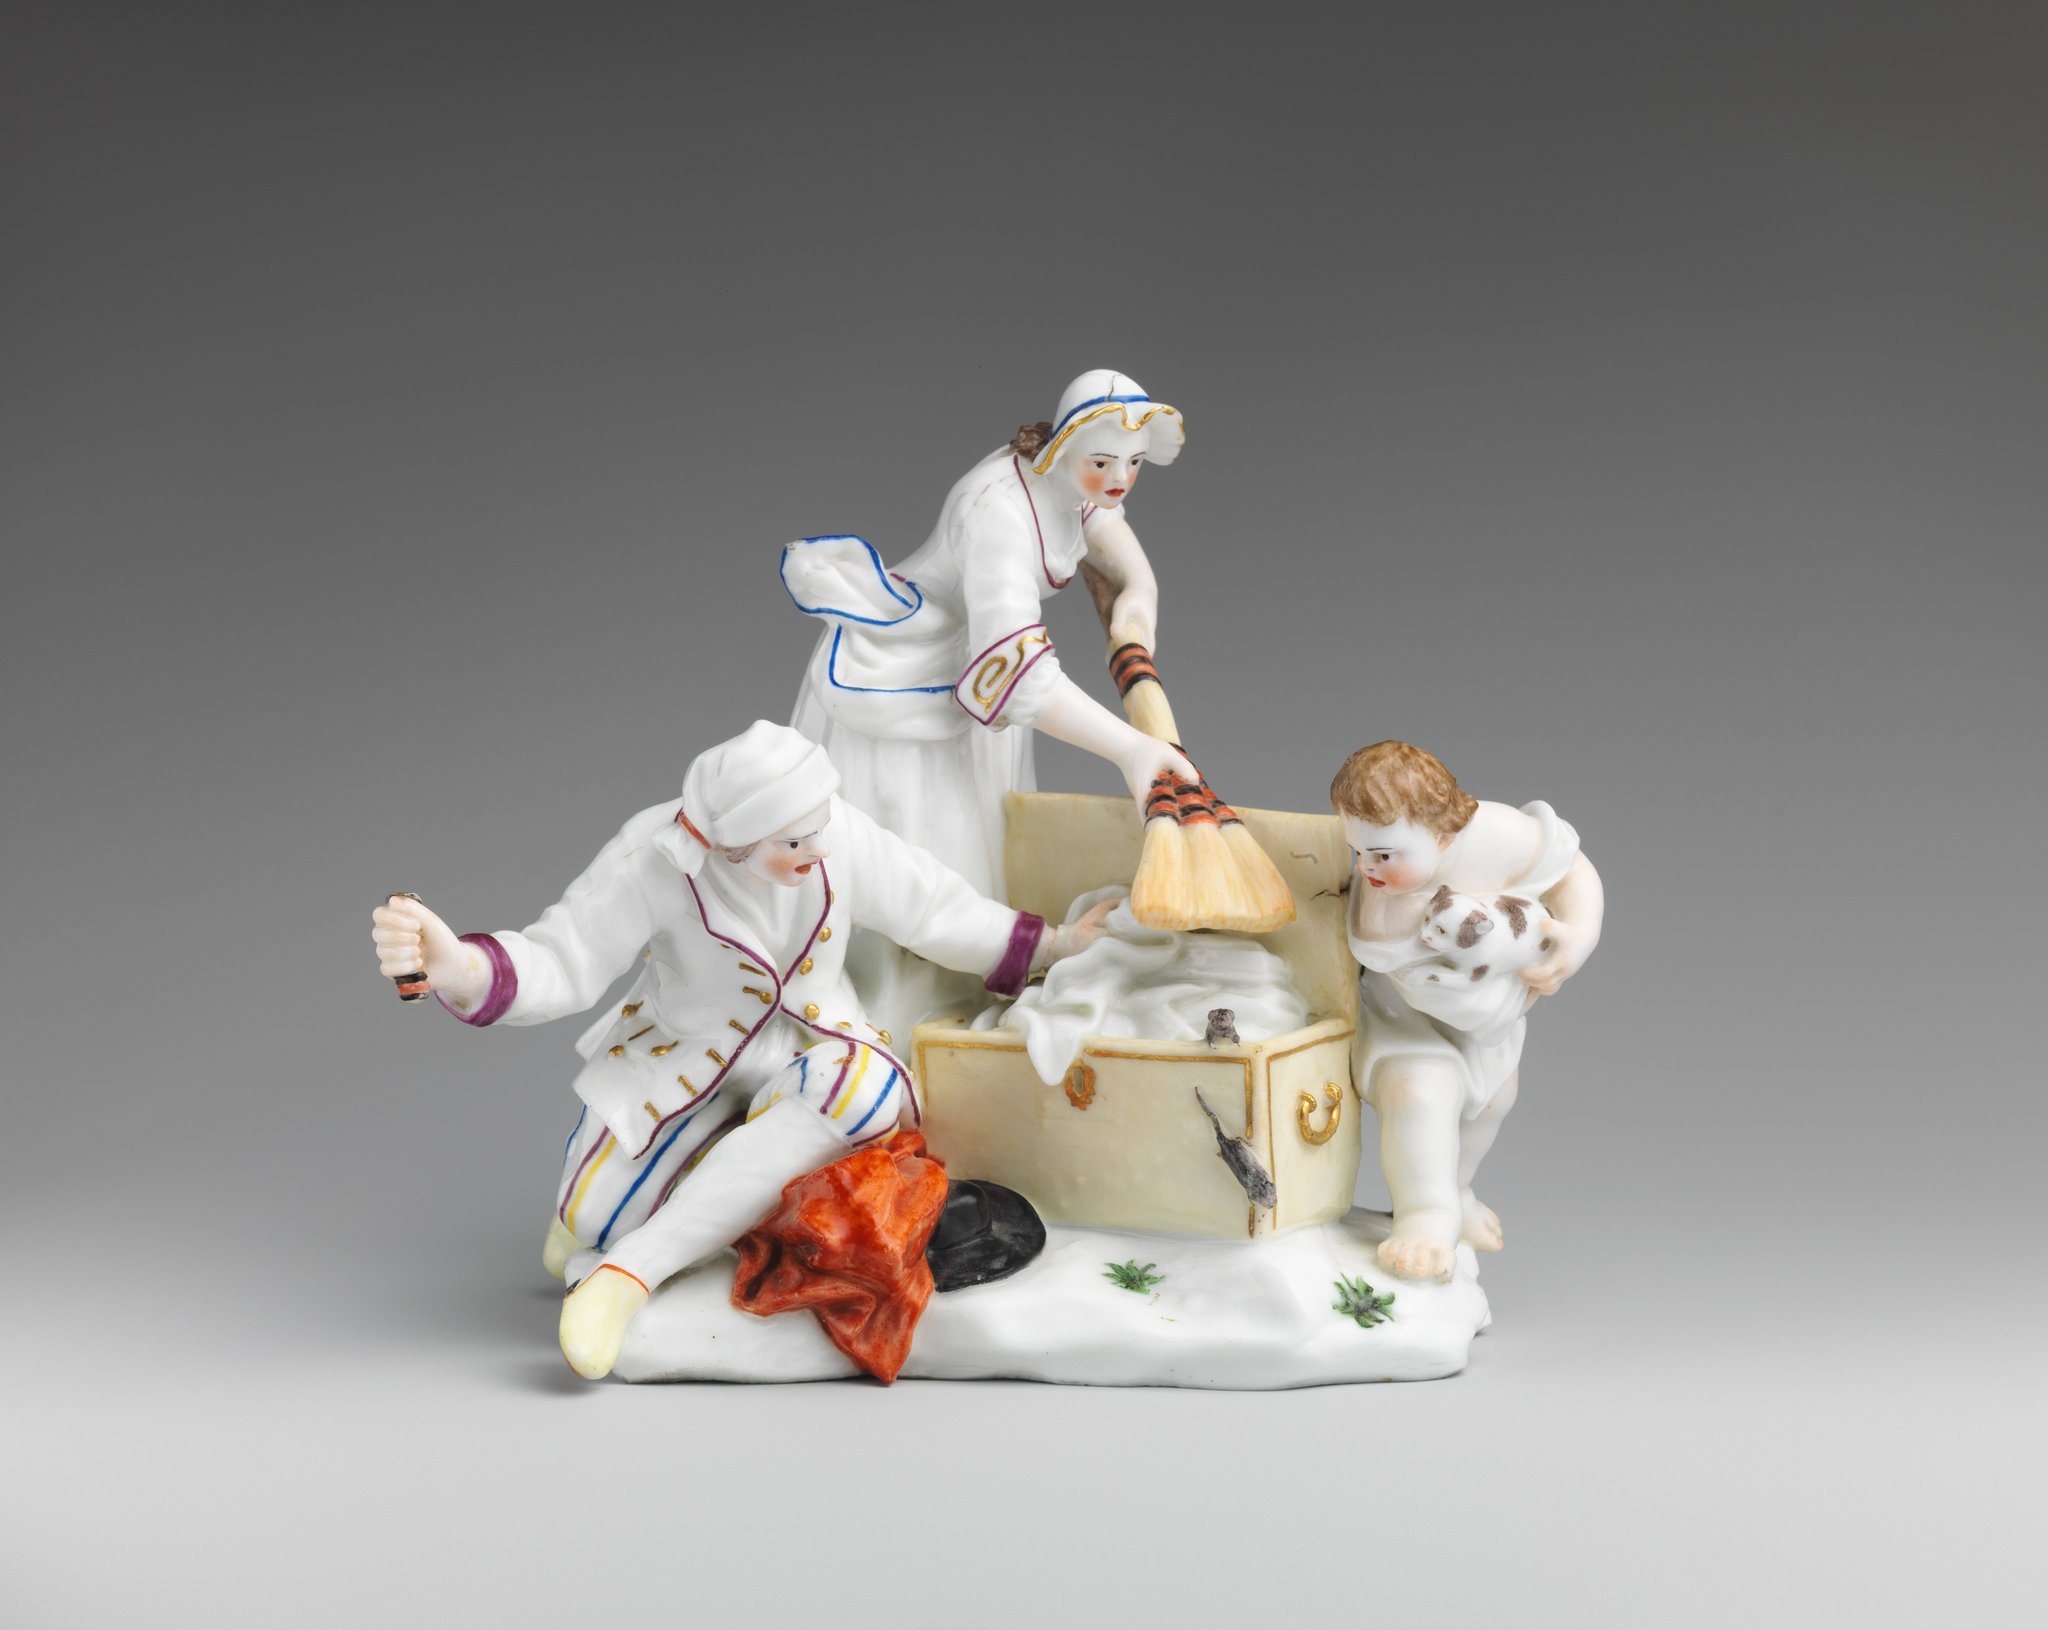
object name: figure group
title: The Mouse Catchers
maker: capodimonte porcelain manufactory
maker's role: manufactory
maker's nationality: italian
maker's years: 1740-1759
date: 1745-1750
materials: soft paste porcelain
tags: children,men,women,mice